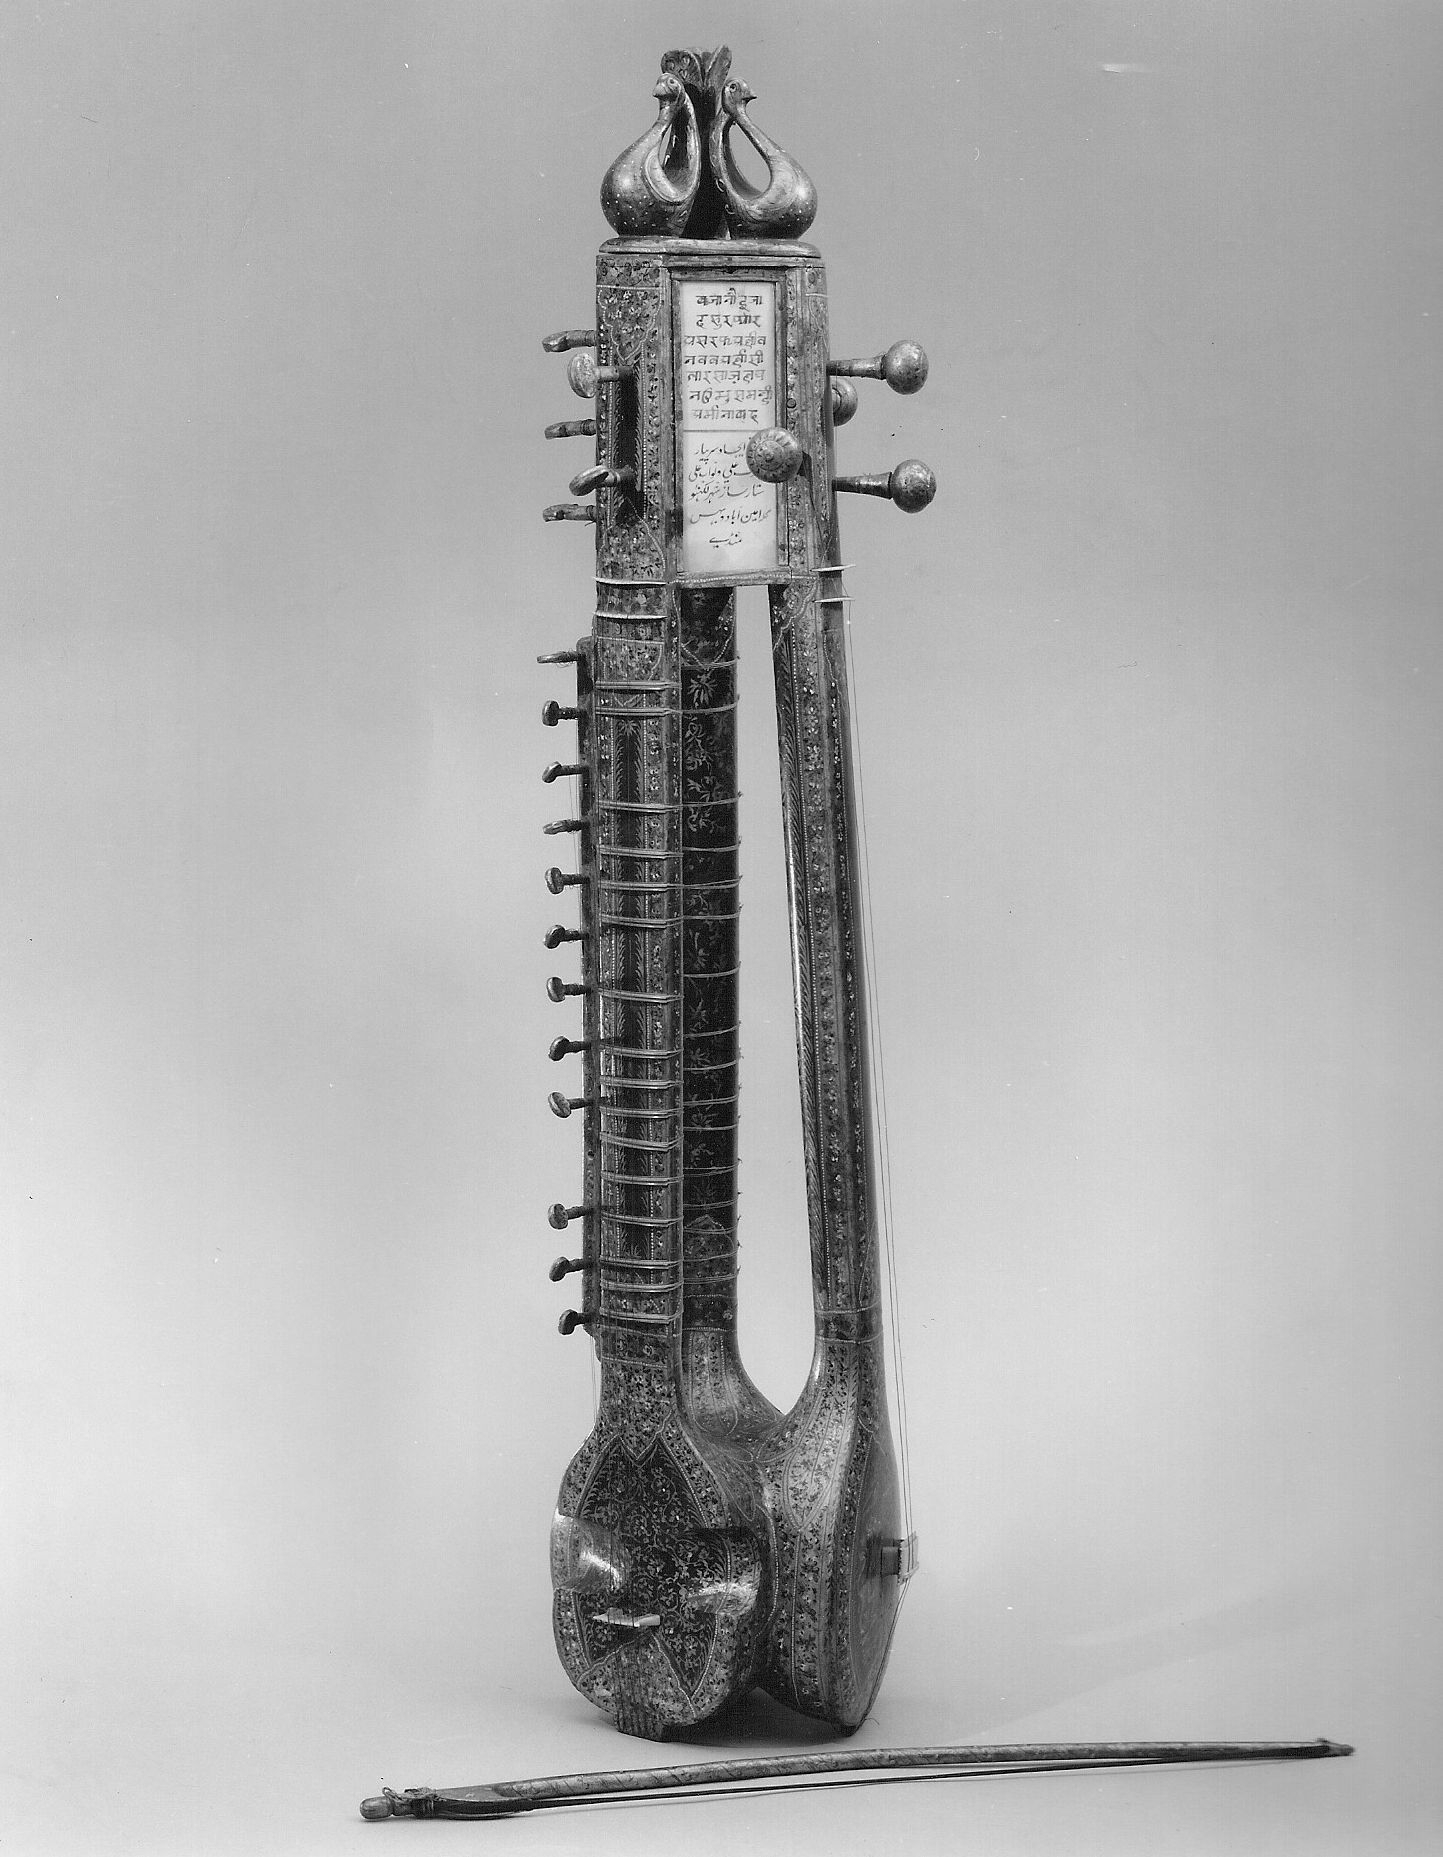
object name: sūr pyār compound sitar, tambura, esraj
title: Sūr pyār (Compound Sitar, Tambura, Esraj)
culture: indian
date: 1867-1900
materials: ivory, metal, steel, wood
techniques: polychrome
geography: india